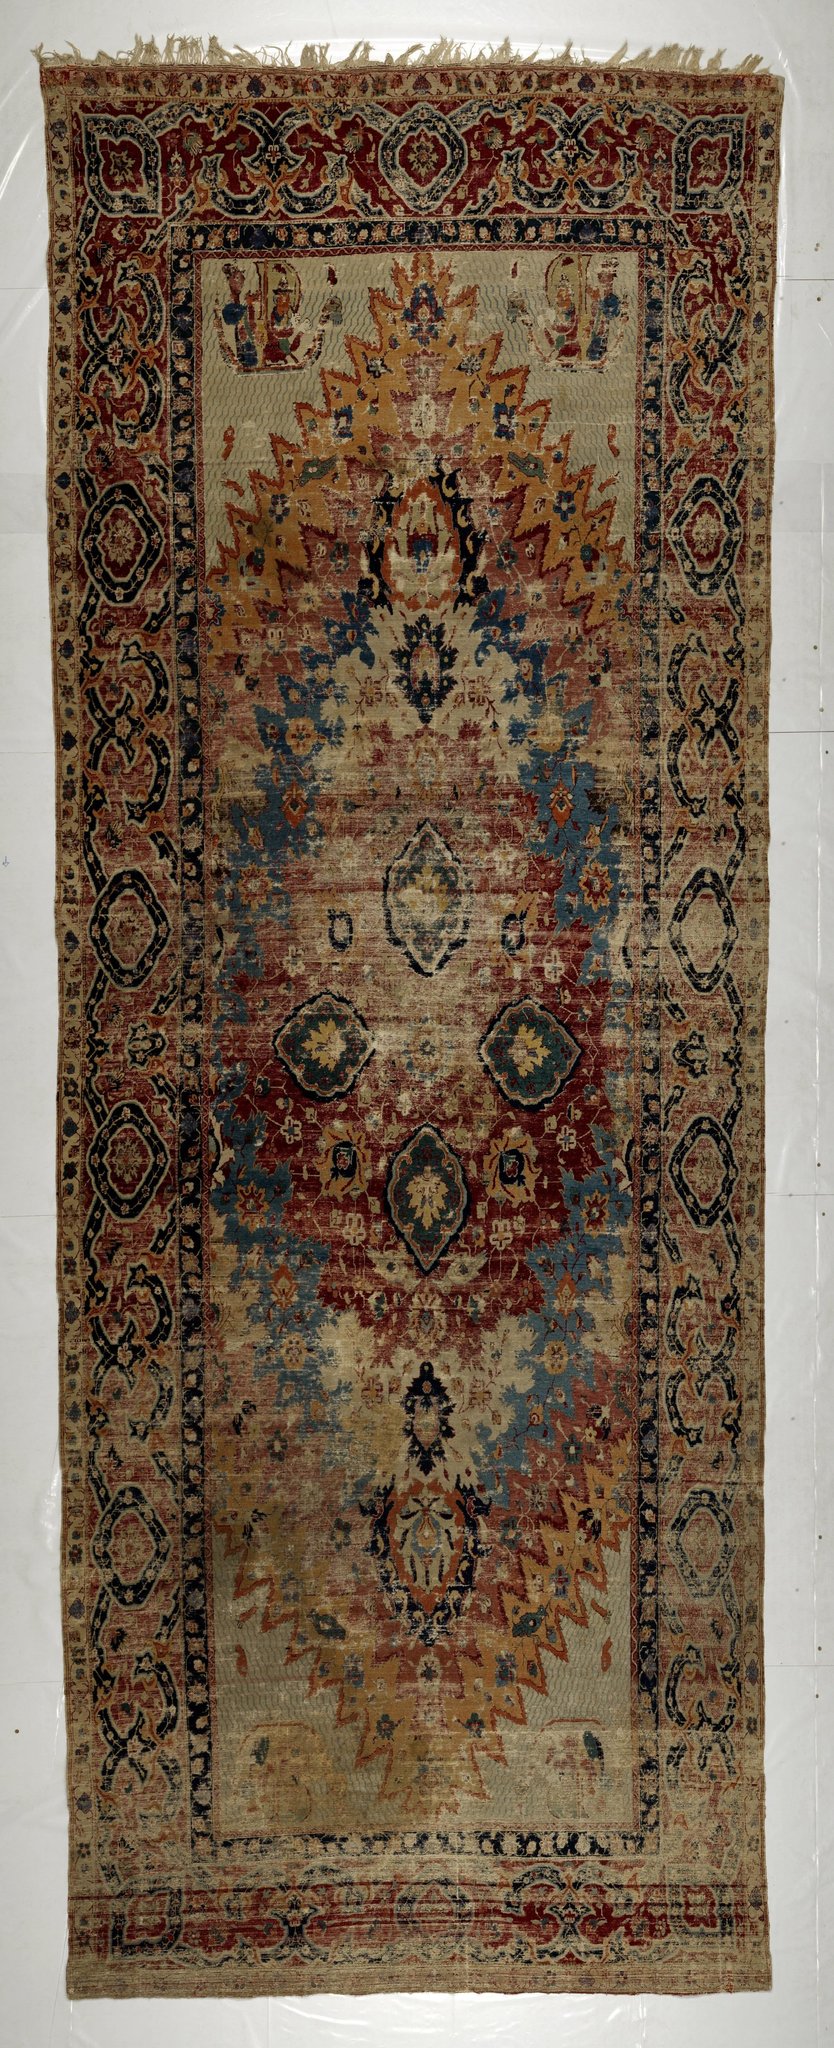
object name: oriental rug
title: Tapijt met in het midden concentrische medaillons met florale ranken en vogels en in de hoeken schepen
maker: Anonymous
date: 1600-1650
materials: wool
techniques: senneh knot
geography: iran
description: Tapijt, zogenaamd Portugees tapijt. Op het middenveld concentrische medaillons versierd met florale ranken en soms met vogels; vlammende contouren. In de hoeken van het middenveld schepen met twee figuren. Rondom een rode rand met blauwe banden die ovalen vormen, waaruit symmetrische arabeskranken ontspringen, uitlopend in bladvormen.